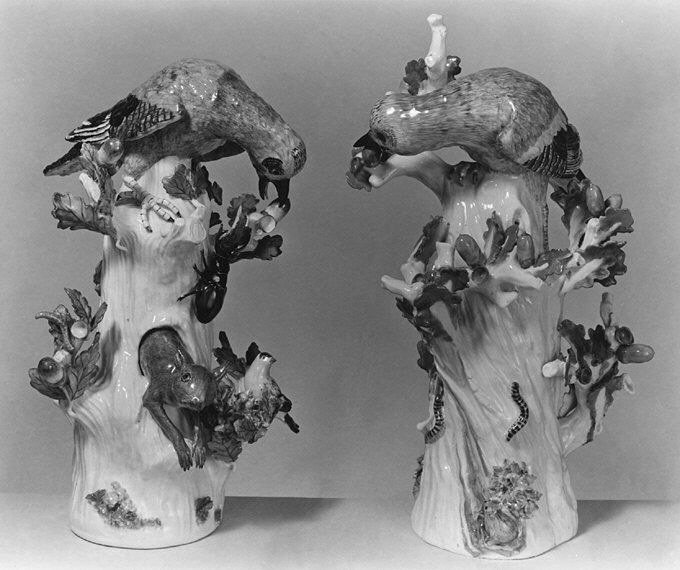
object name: figure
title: Jay (one of a pair)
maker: meissen manufactory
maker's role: manufactory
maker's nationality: german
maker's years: 1710-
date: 1740-1745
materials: hard paste porcelain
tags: birds,insects